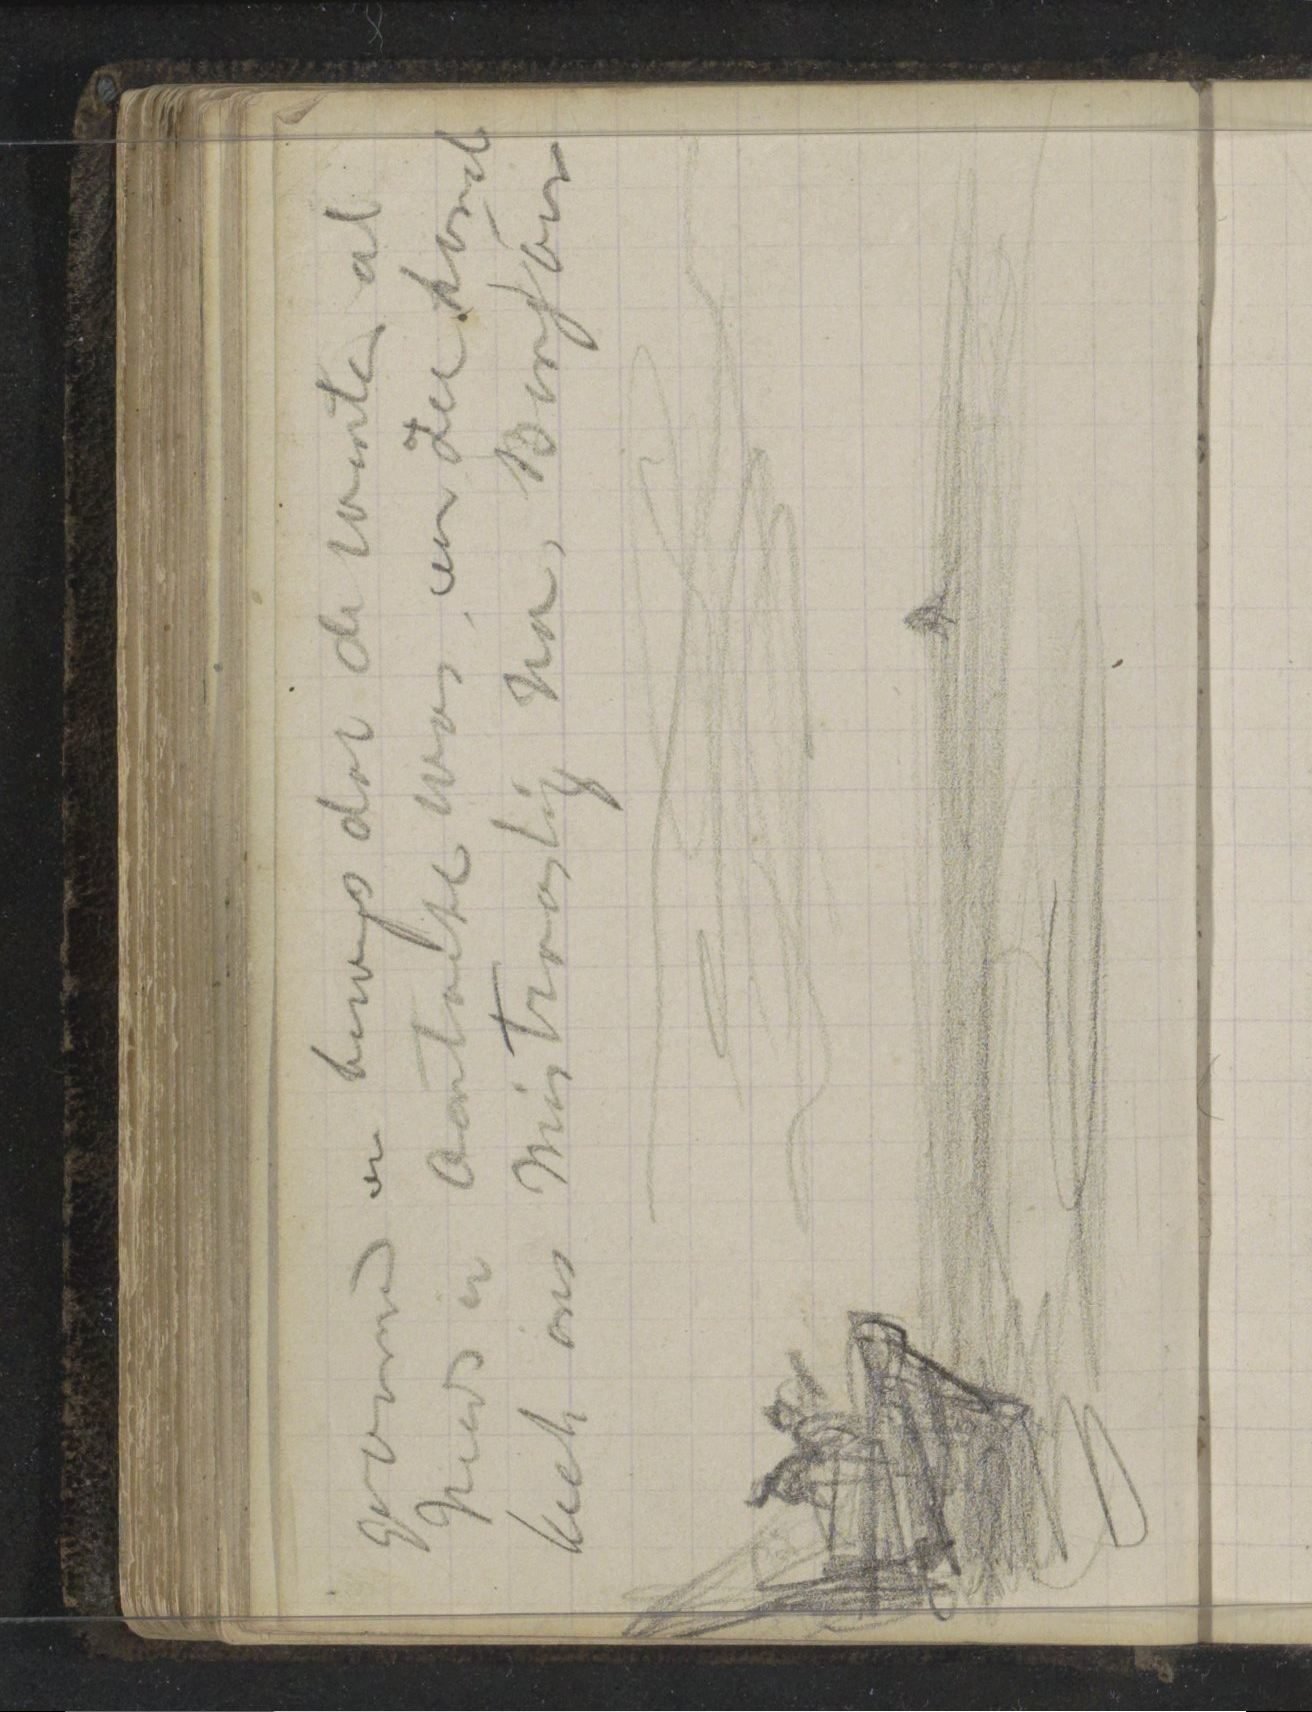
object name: sketchbook leaf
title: Reisverslag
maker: louis apol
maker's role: draughtsman, painter, print maker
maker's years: 1850-1936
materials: pencil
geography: barentsz sea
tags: nova zembla expedities 1880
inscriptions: annotation: ‘[...]’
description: Blad 69 verso uit een schetsboek met 110 bladen betekend tijdens de expeditie naar Nova Zembla in 1880.